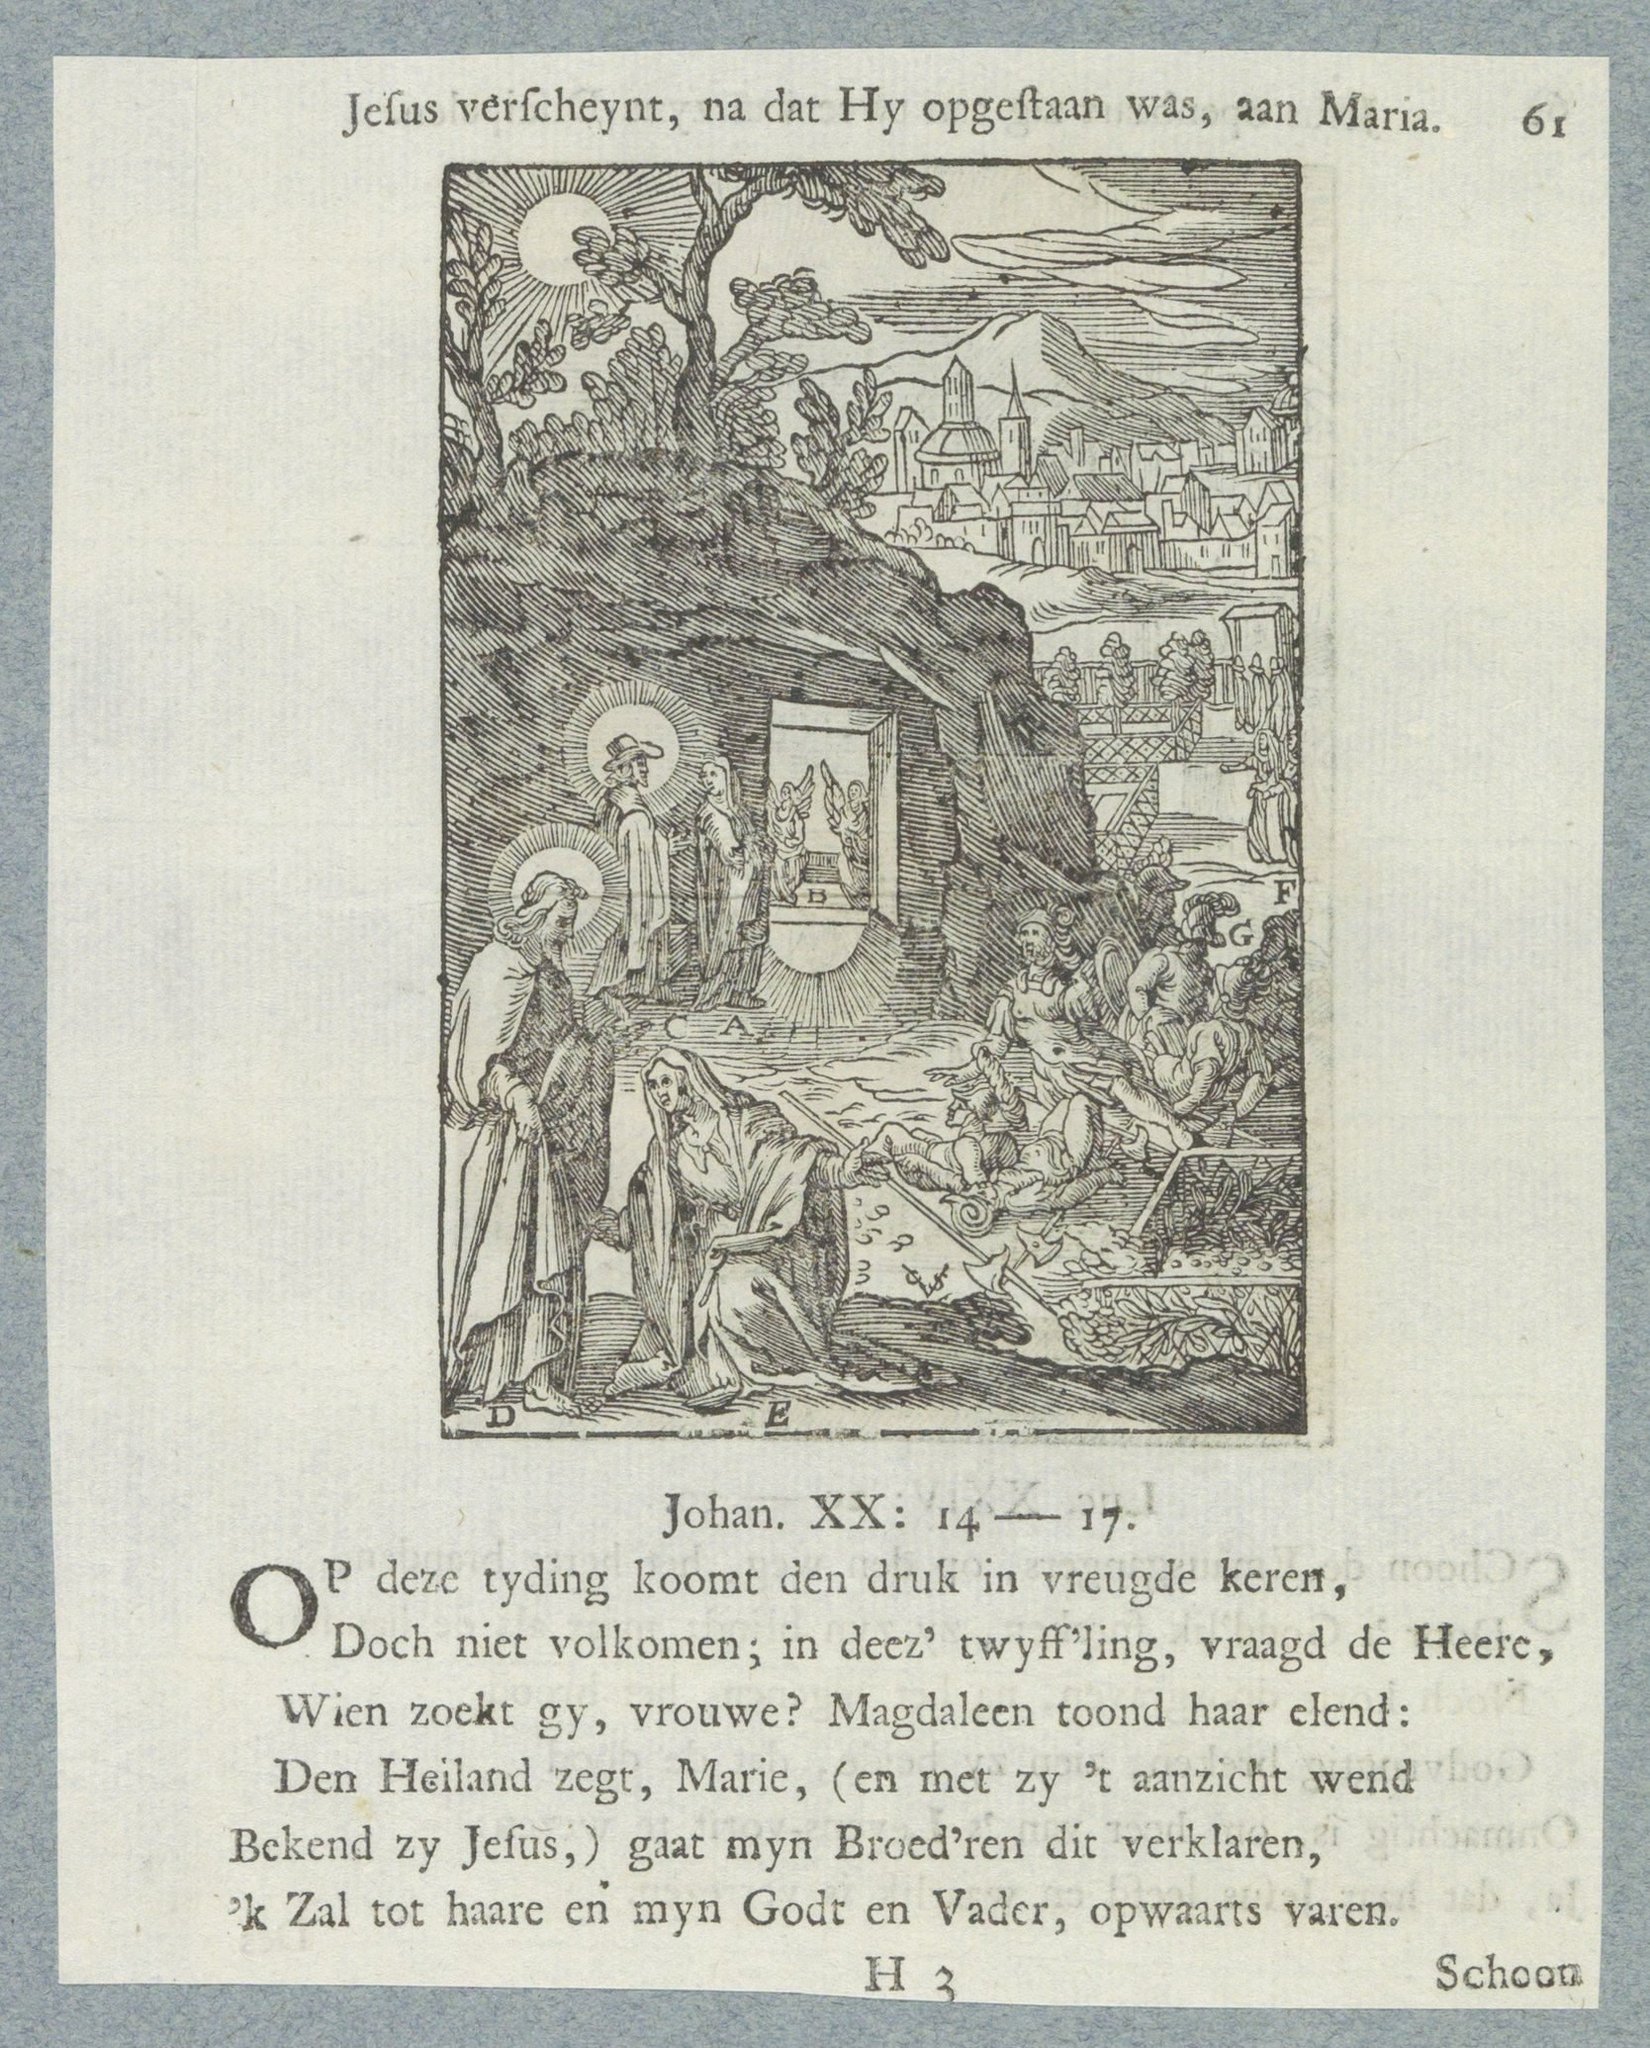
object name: book illustration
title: Jesus verscheynt, na dat Hy opgestaan was, aan Maria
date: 1629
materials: paper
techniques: letterpress printing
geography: amsterdam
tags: mary magdalene kneeling before christ, who is usually represented as a gardener with a hoe and/or a spade; 'noli me tangere', angel(s) in or at the empty tomb of christ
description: De prent is afkomstig uit: Bybels Lusthof. Amsterdam, J. Klooster, 1740. De prent werd gemaakt voor de uitgaven van P.J. Paets uit Amsterdam, verschenen in de jaren 1629-1648. Ze komt voor het eerst voor in: Der Zielen Lust-hof. Leuven, I.Jacbosz voor P.J. Paets [= Amsterdam, P.J. Paets], 1629. De voorstelling is gekopieerd naar een prent van Hieronymus Wierix voor: Nadal, Jerónimo. Evangelicae Historiae Imagines. Antwerpen, M. Nutius, 1593.